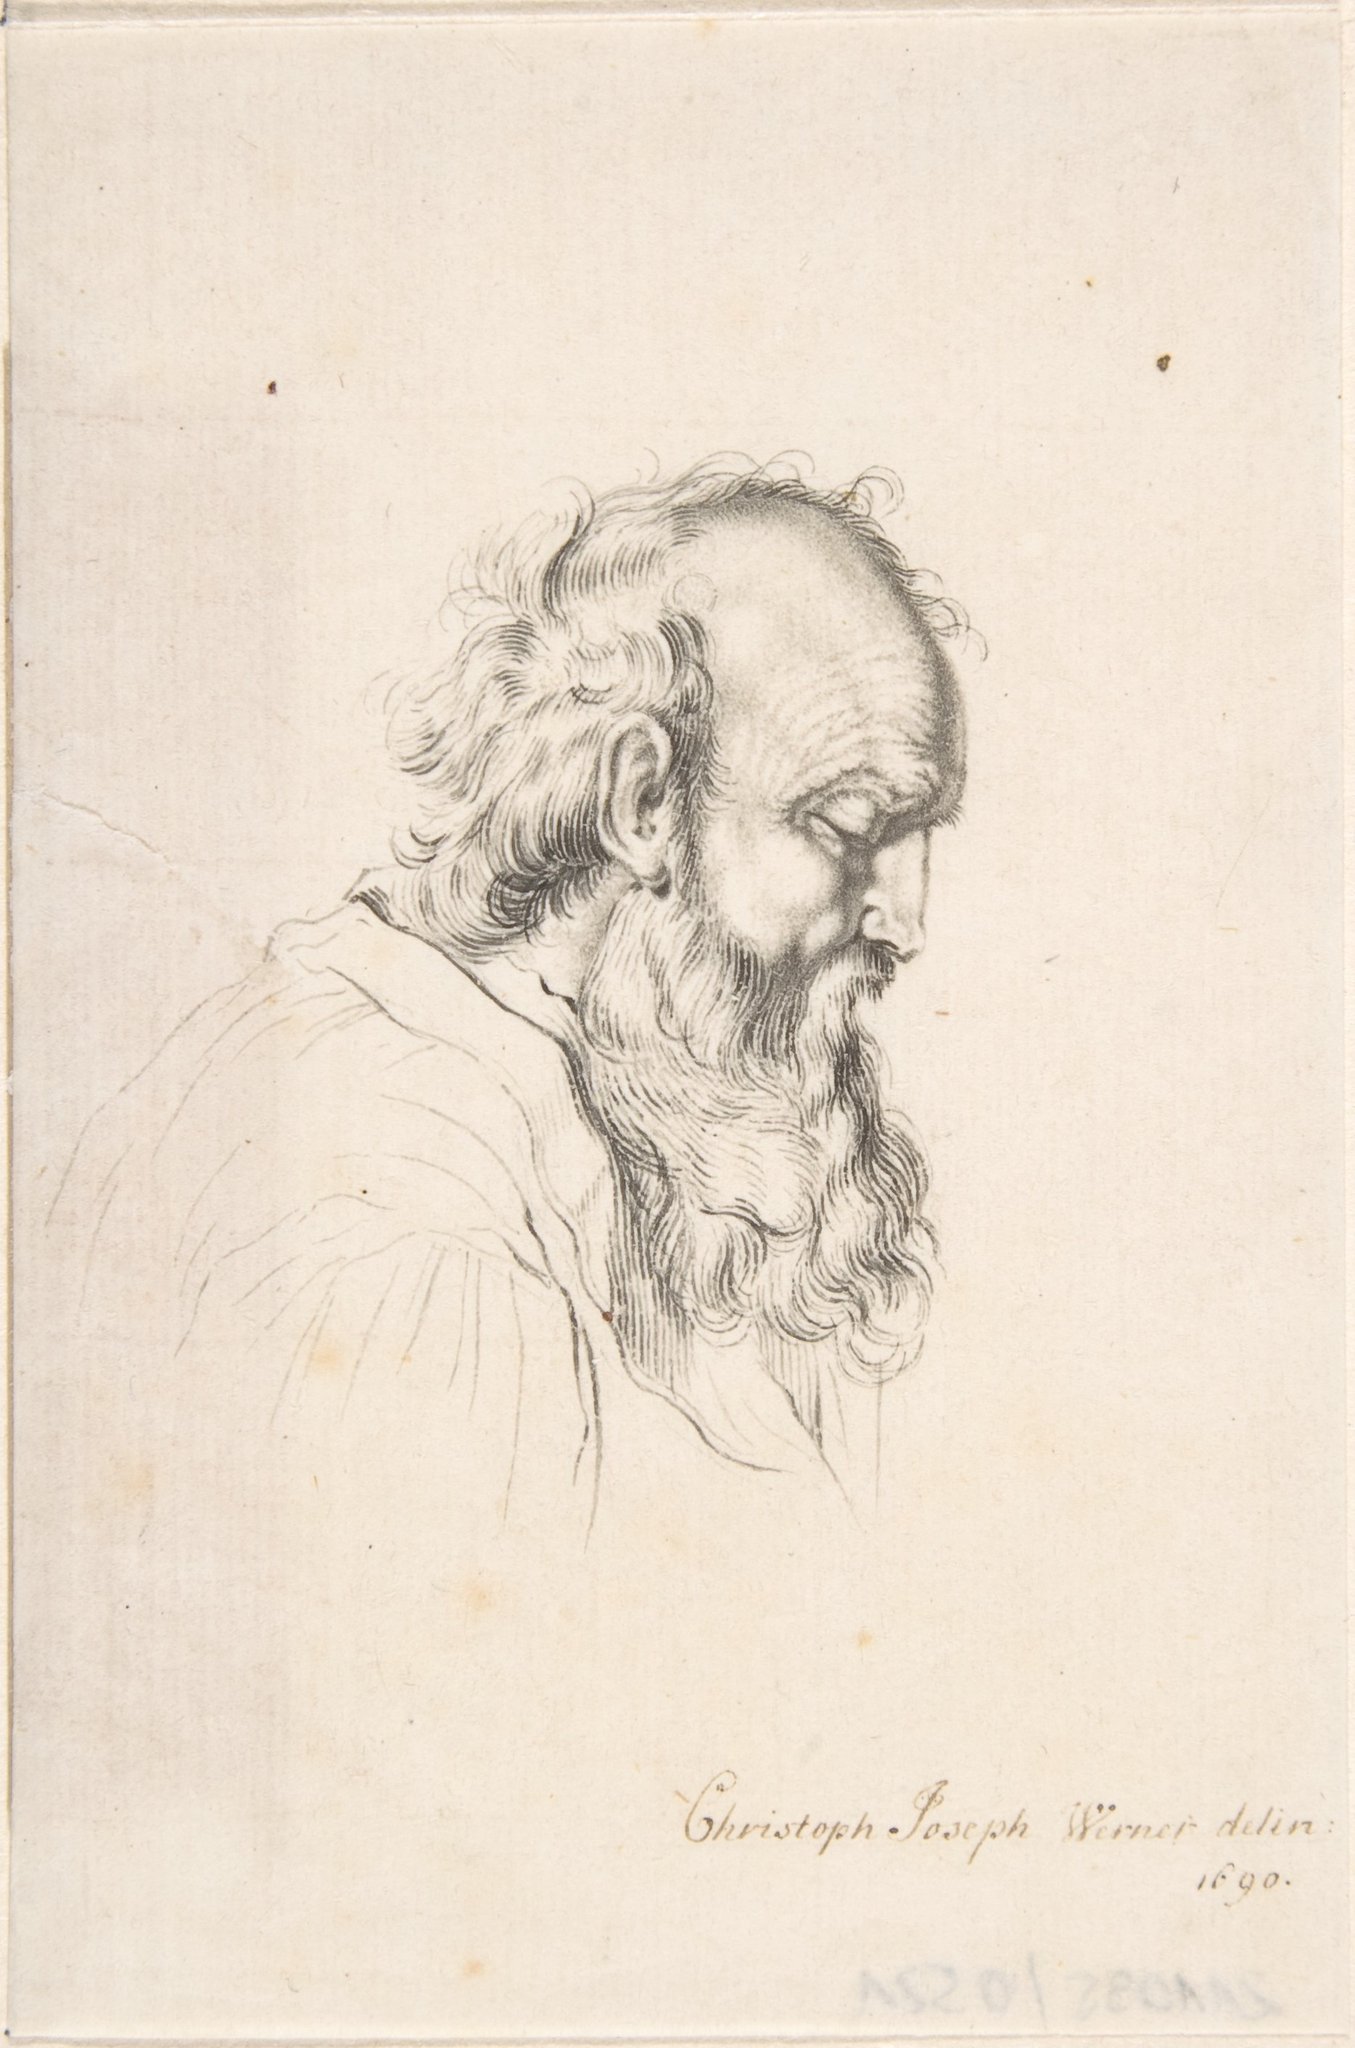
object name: drawing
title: Bearded Man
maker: christoph joseph werner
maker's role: artist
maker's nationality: german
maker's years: 1670-1750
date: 1690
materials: ink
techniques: brush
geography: germany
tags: men,profiles